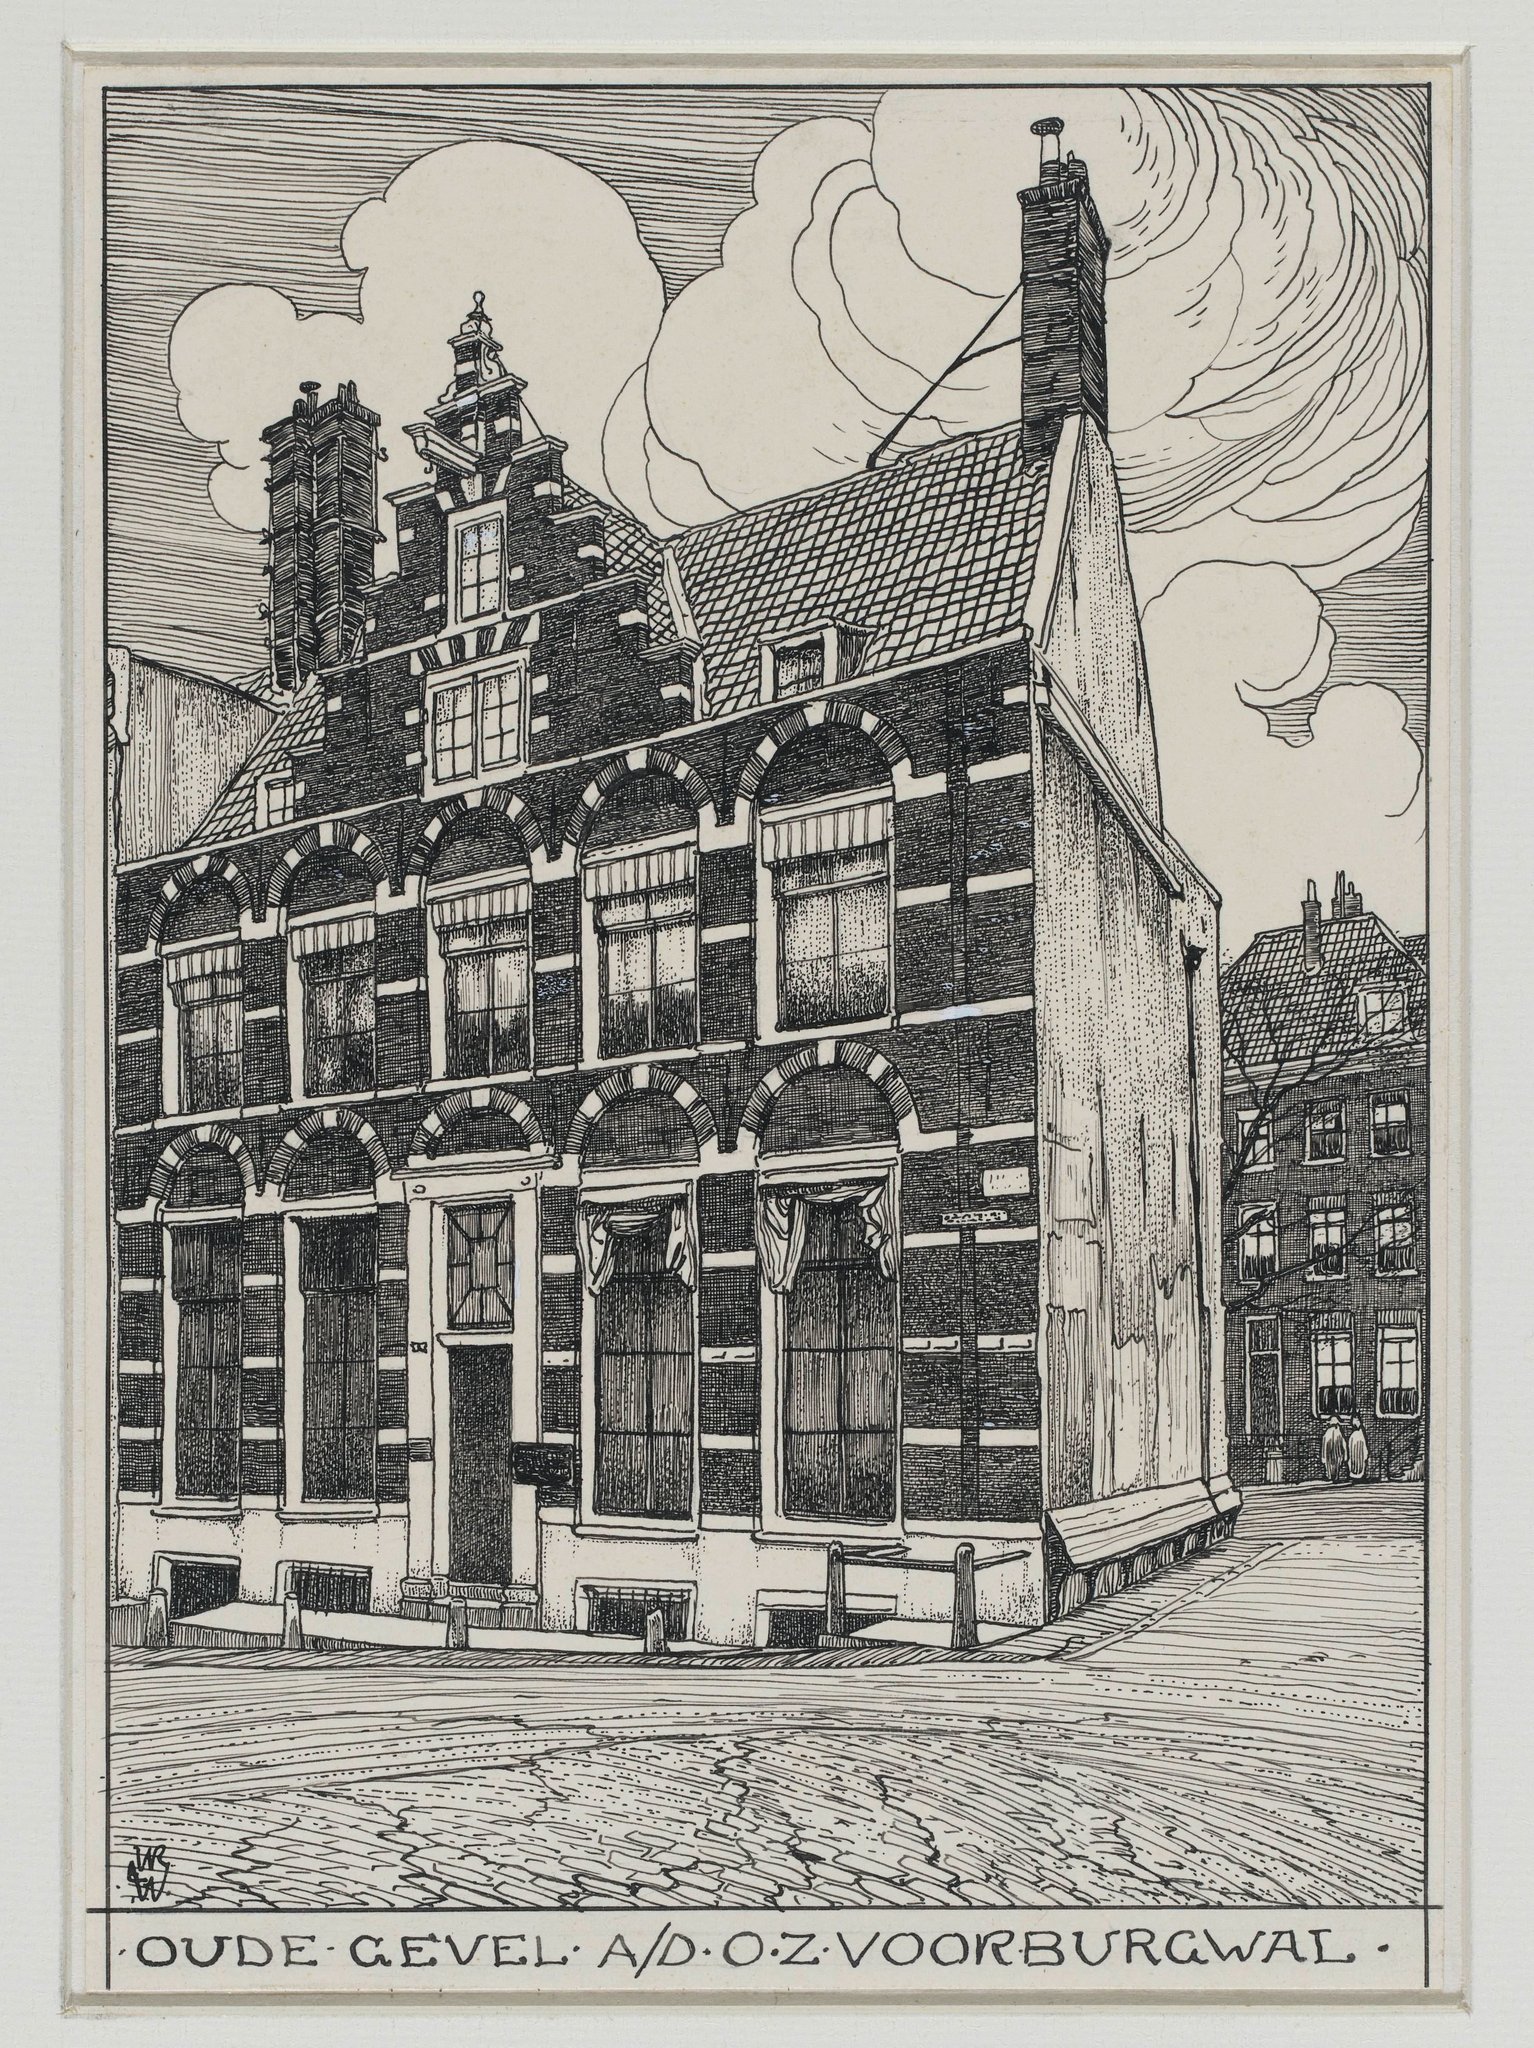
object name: drawing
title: Oude gevel aan de Oudezijds Voorburgwal te Amsterdam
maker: willem wenckebach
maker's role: designer, draughtsman, painter, print maker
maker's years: 1860-1937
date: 1870-1926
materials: paint, ink, paper, pencil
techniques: pen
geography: amsterdam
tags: street